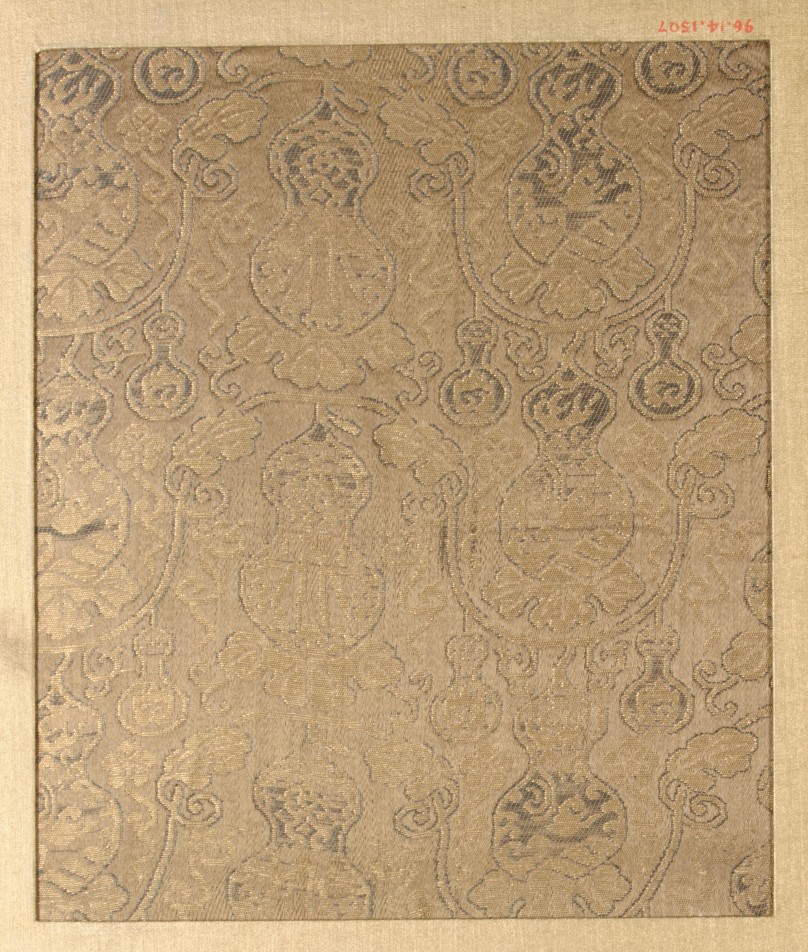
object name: piece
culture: japanese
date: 1701-1900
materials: silk